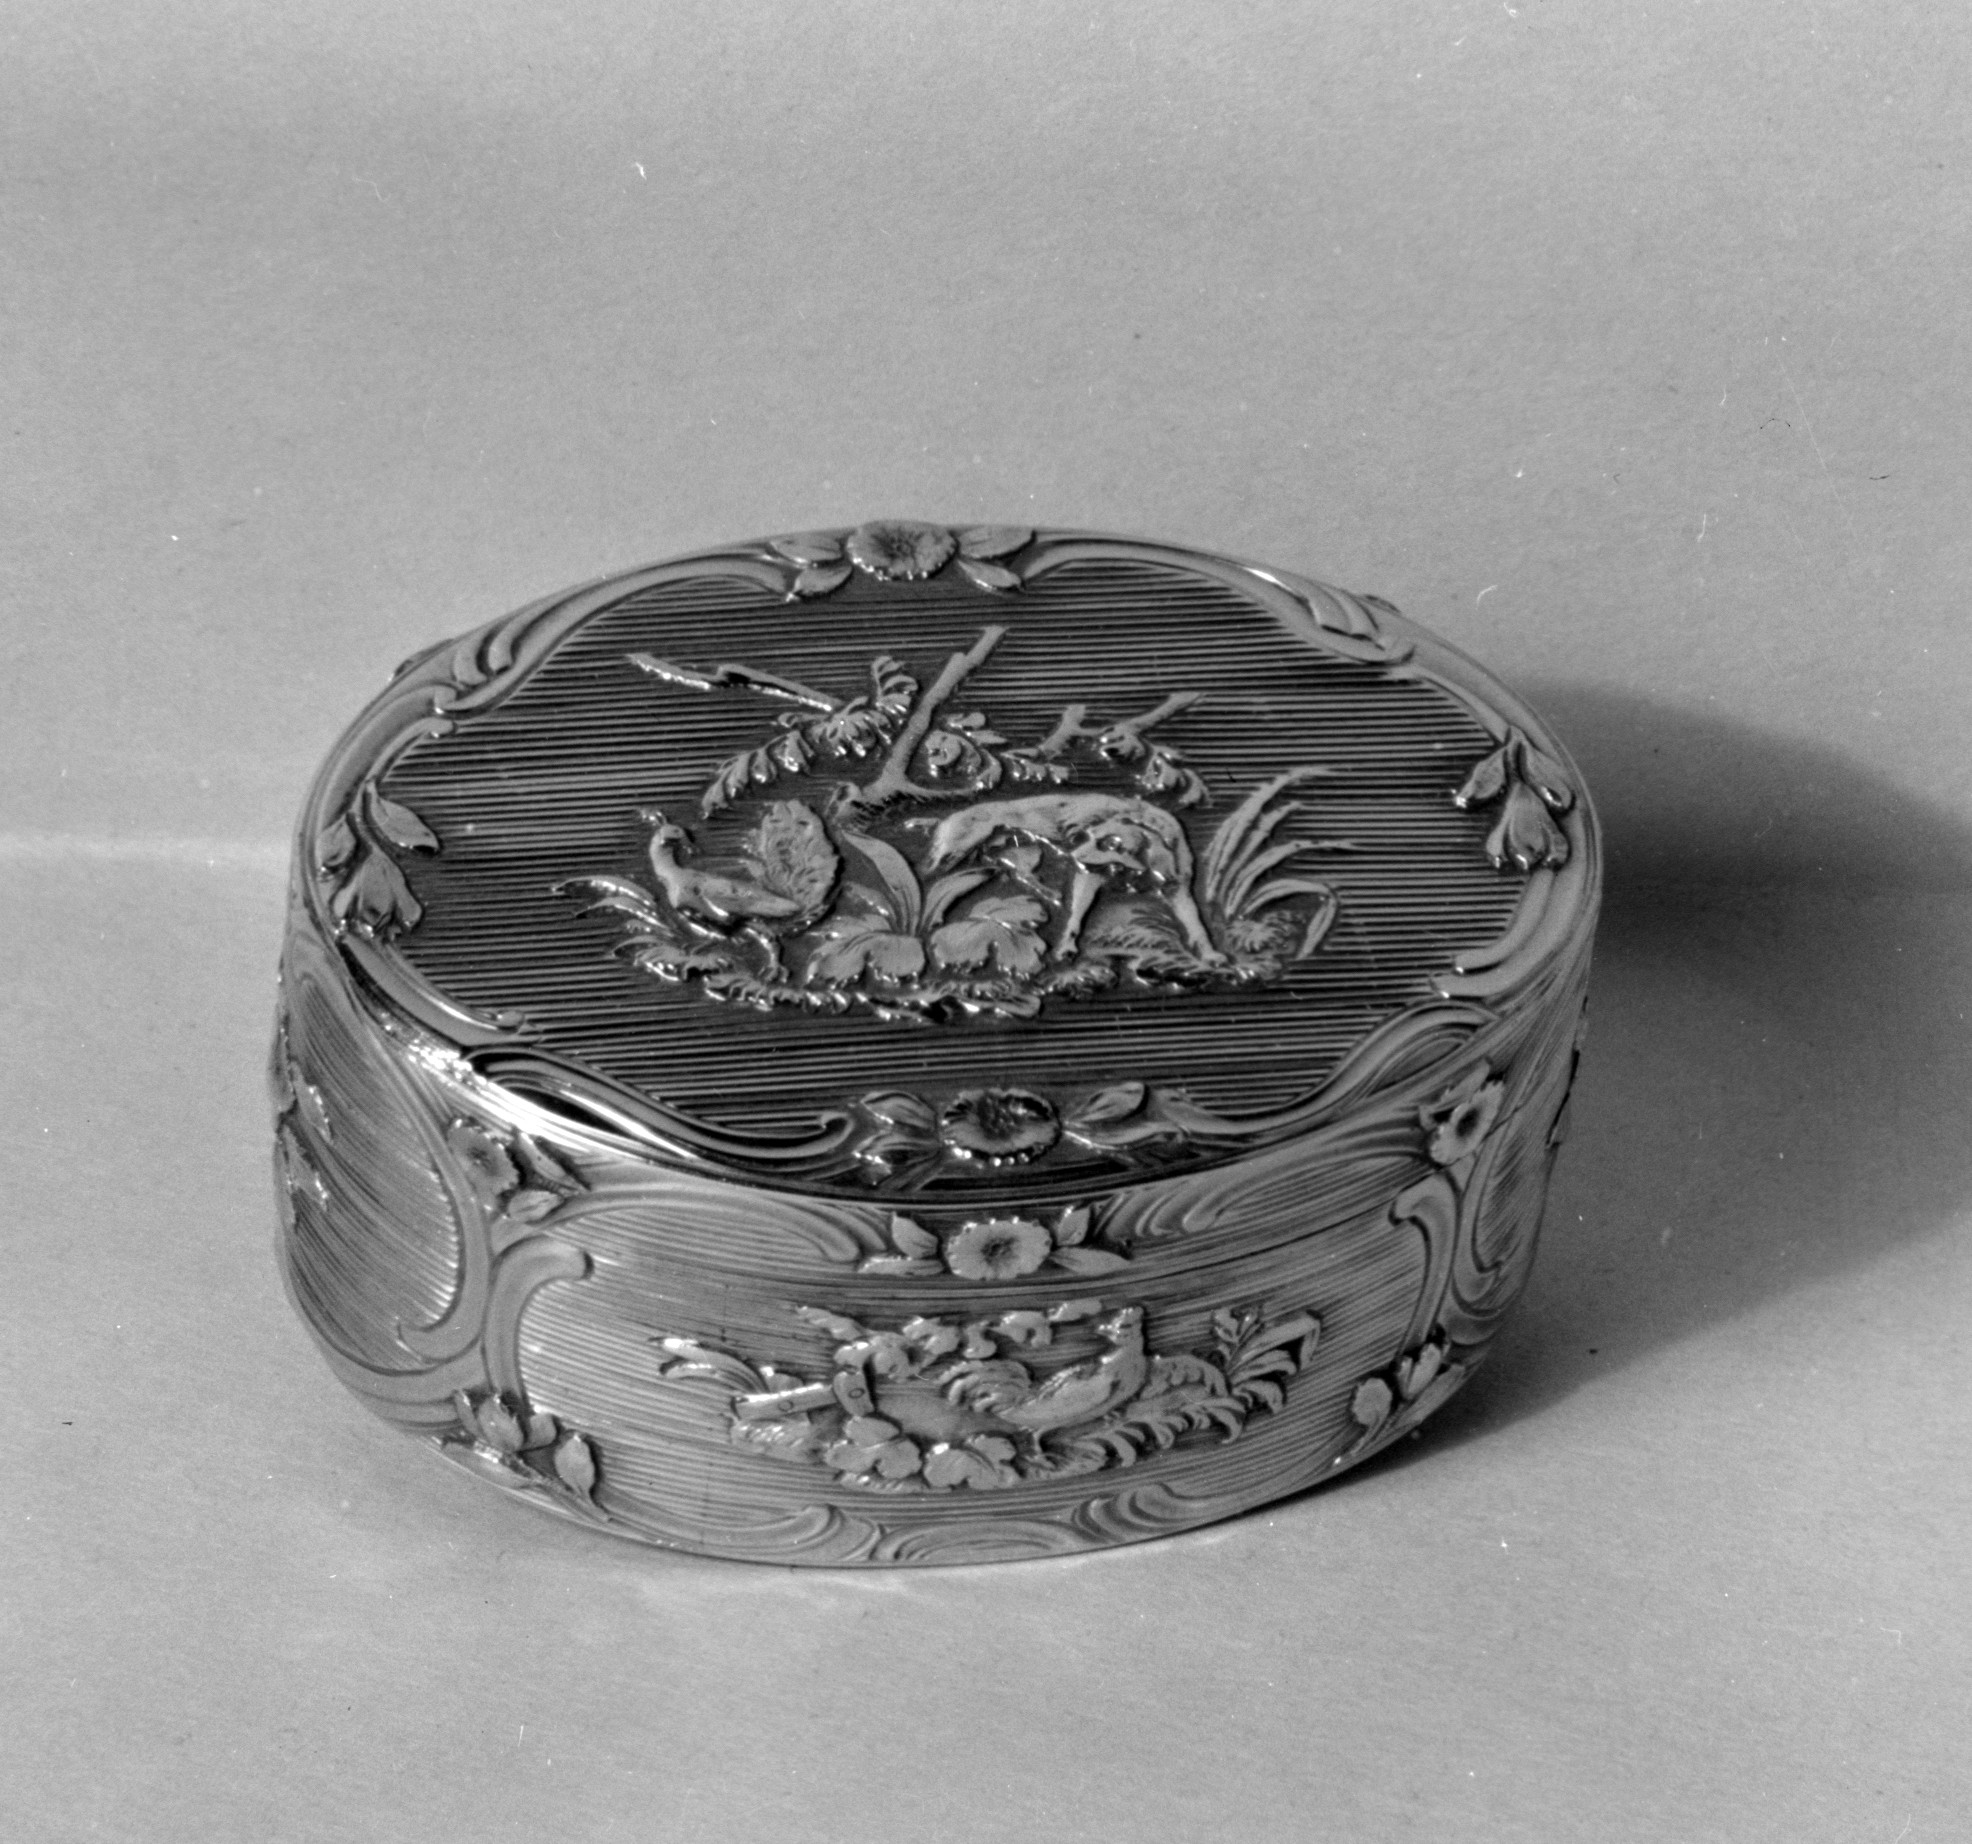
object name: patch box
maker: jean formey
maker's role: maker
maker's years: 1724-1821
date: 1759-1760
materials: gold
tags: animals,birds